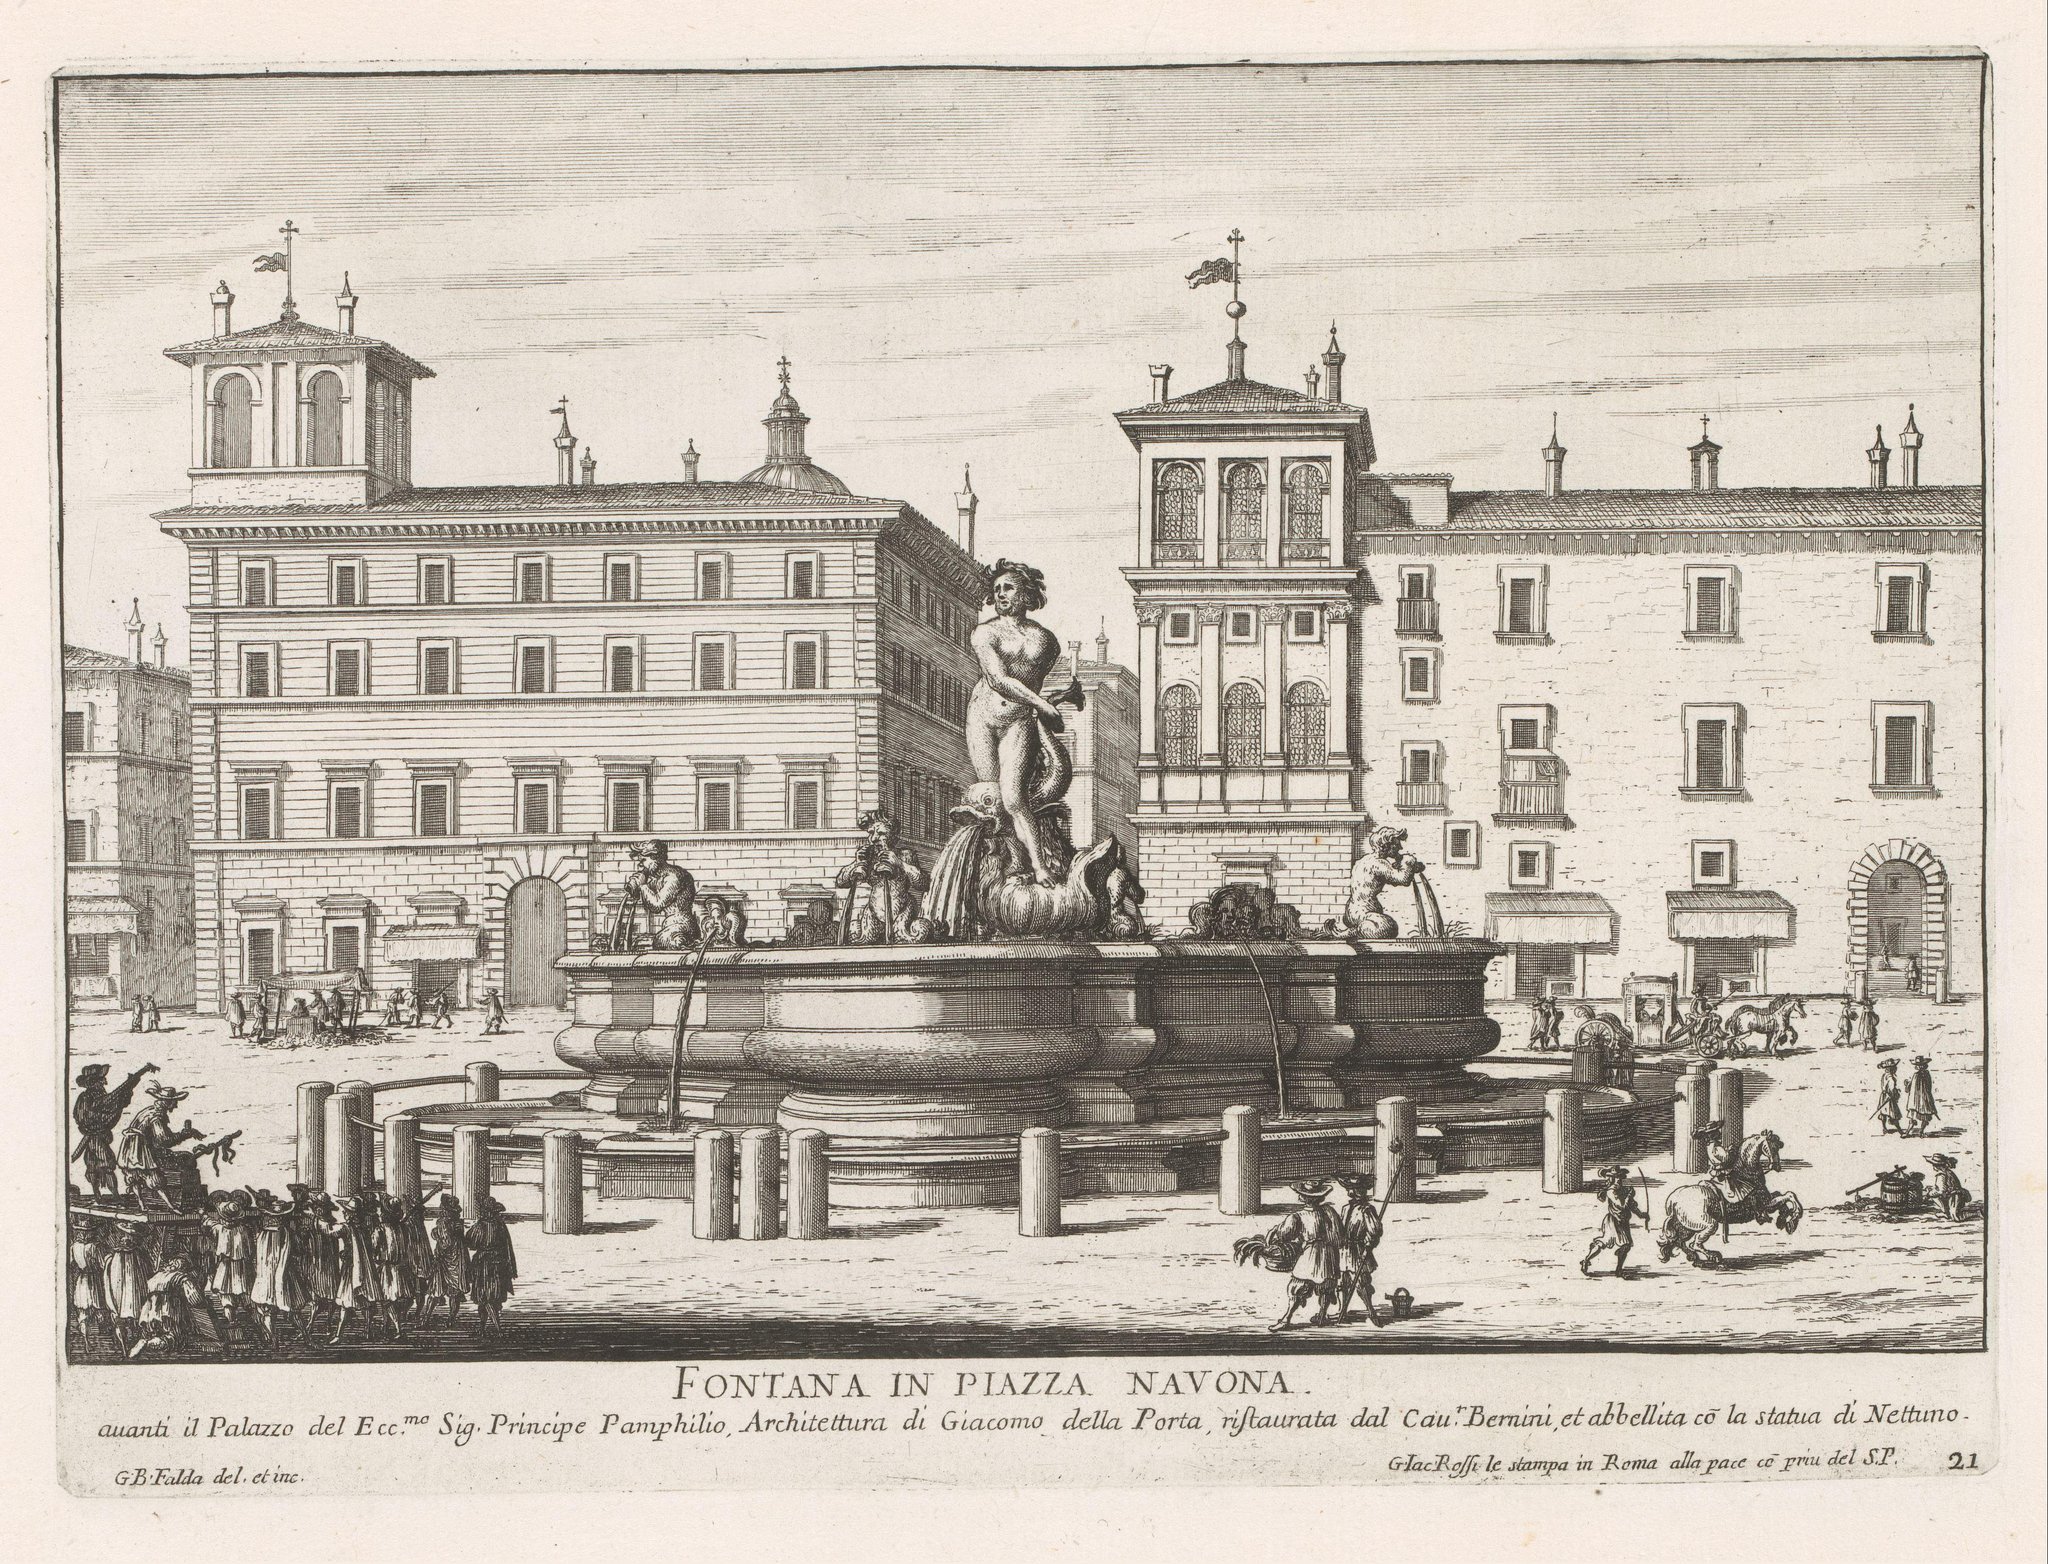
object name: print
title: Fonteinen van Rome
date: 1653-1691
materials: paper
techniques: etching, intaglio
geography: italy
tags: ornamental fountain, rome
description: Genummerd rechtsonder: 21. De prent maakt deel uit van een album.